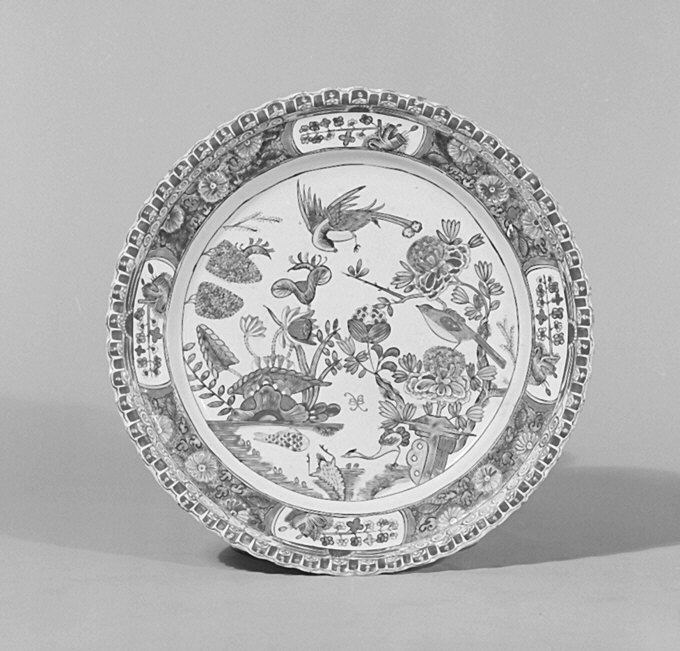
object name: plate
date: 1730-1740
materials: earthenware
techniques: glazing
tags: birds,flowers